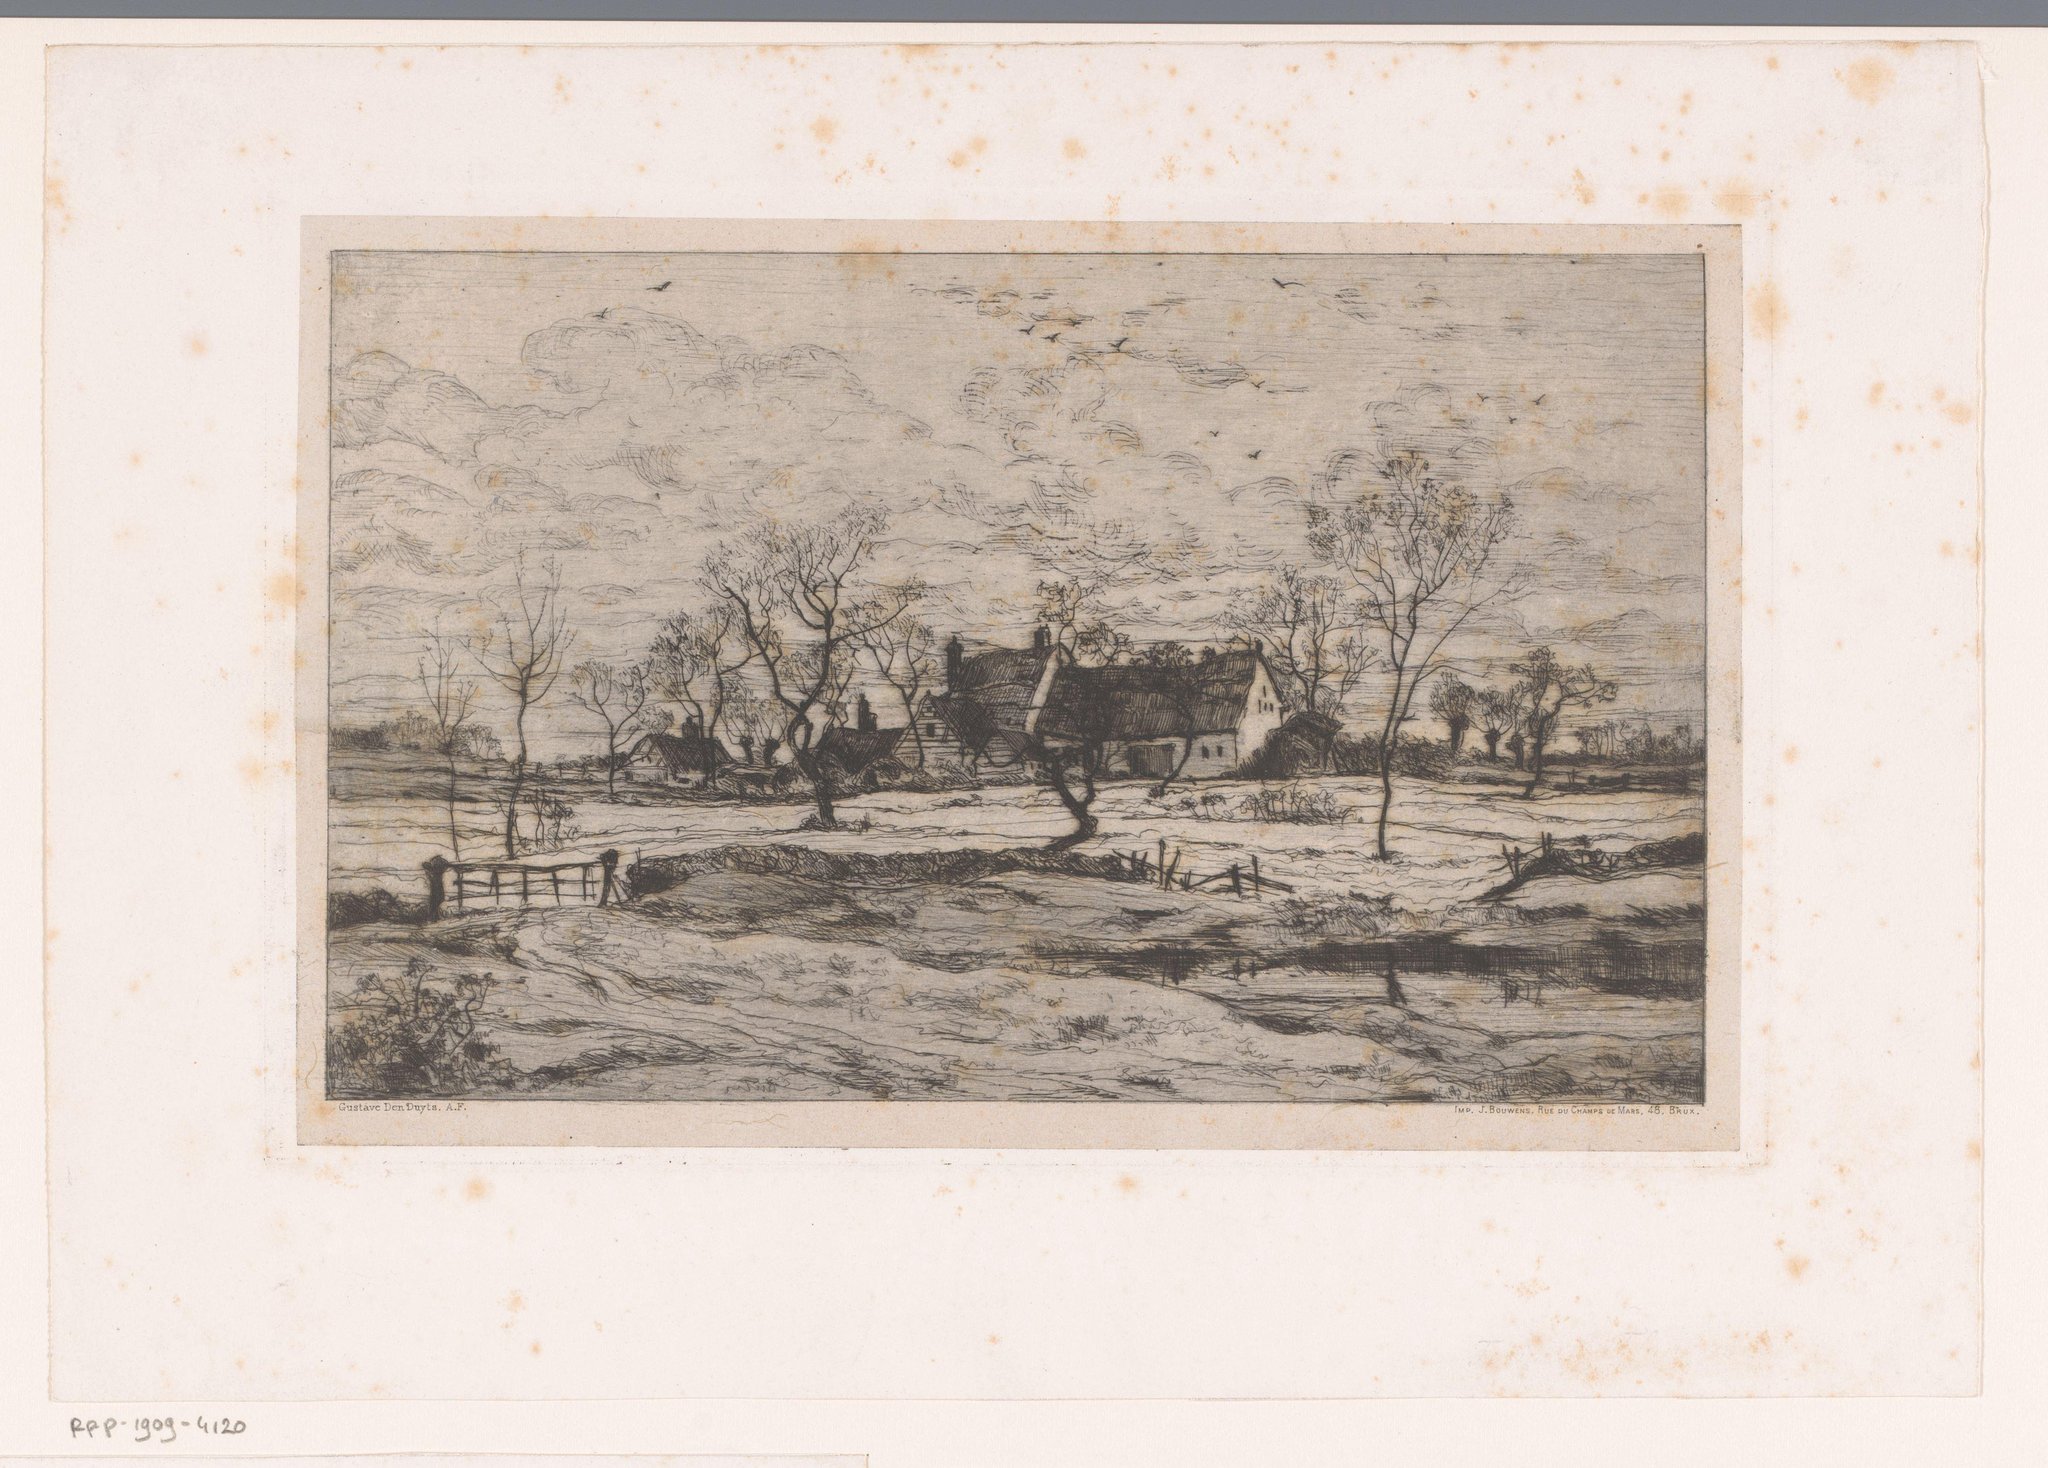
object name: print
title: Landschap met huizen en een beek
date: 1875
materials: paper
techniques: etching, intaglio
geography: brussels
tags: brook, farm or solitary house in landscape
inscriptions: collector's mark: Lugt 2228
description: Deze prent won de tweede prijs bij een wedstrijd in Brussel georganiseerd door de 'Journal des Beaux-Arts et de la Littérature' in 1875. De juryleden waren: Eugène de Block, Kindermans en David Joseph Desvachez.